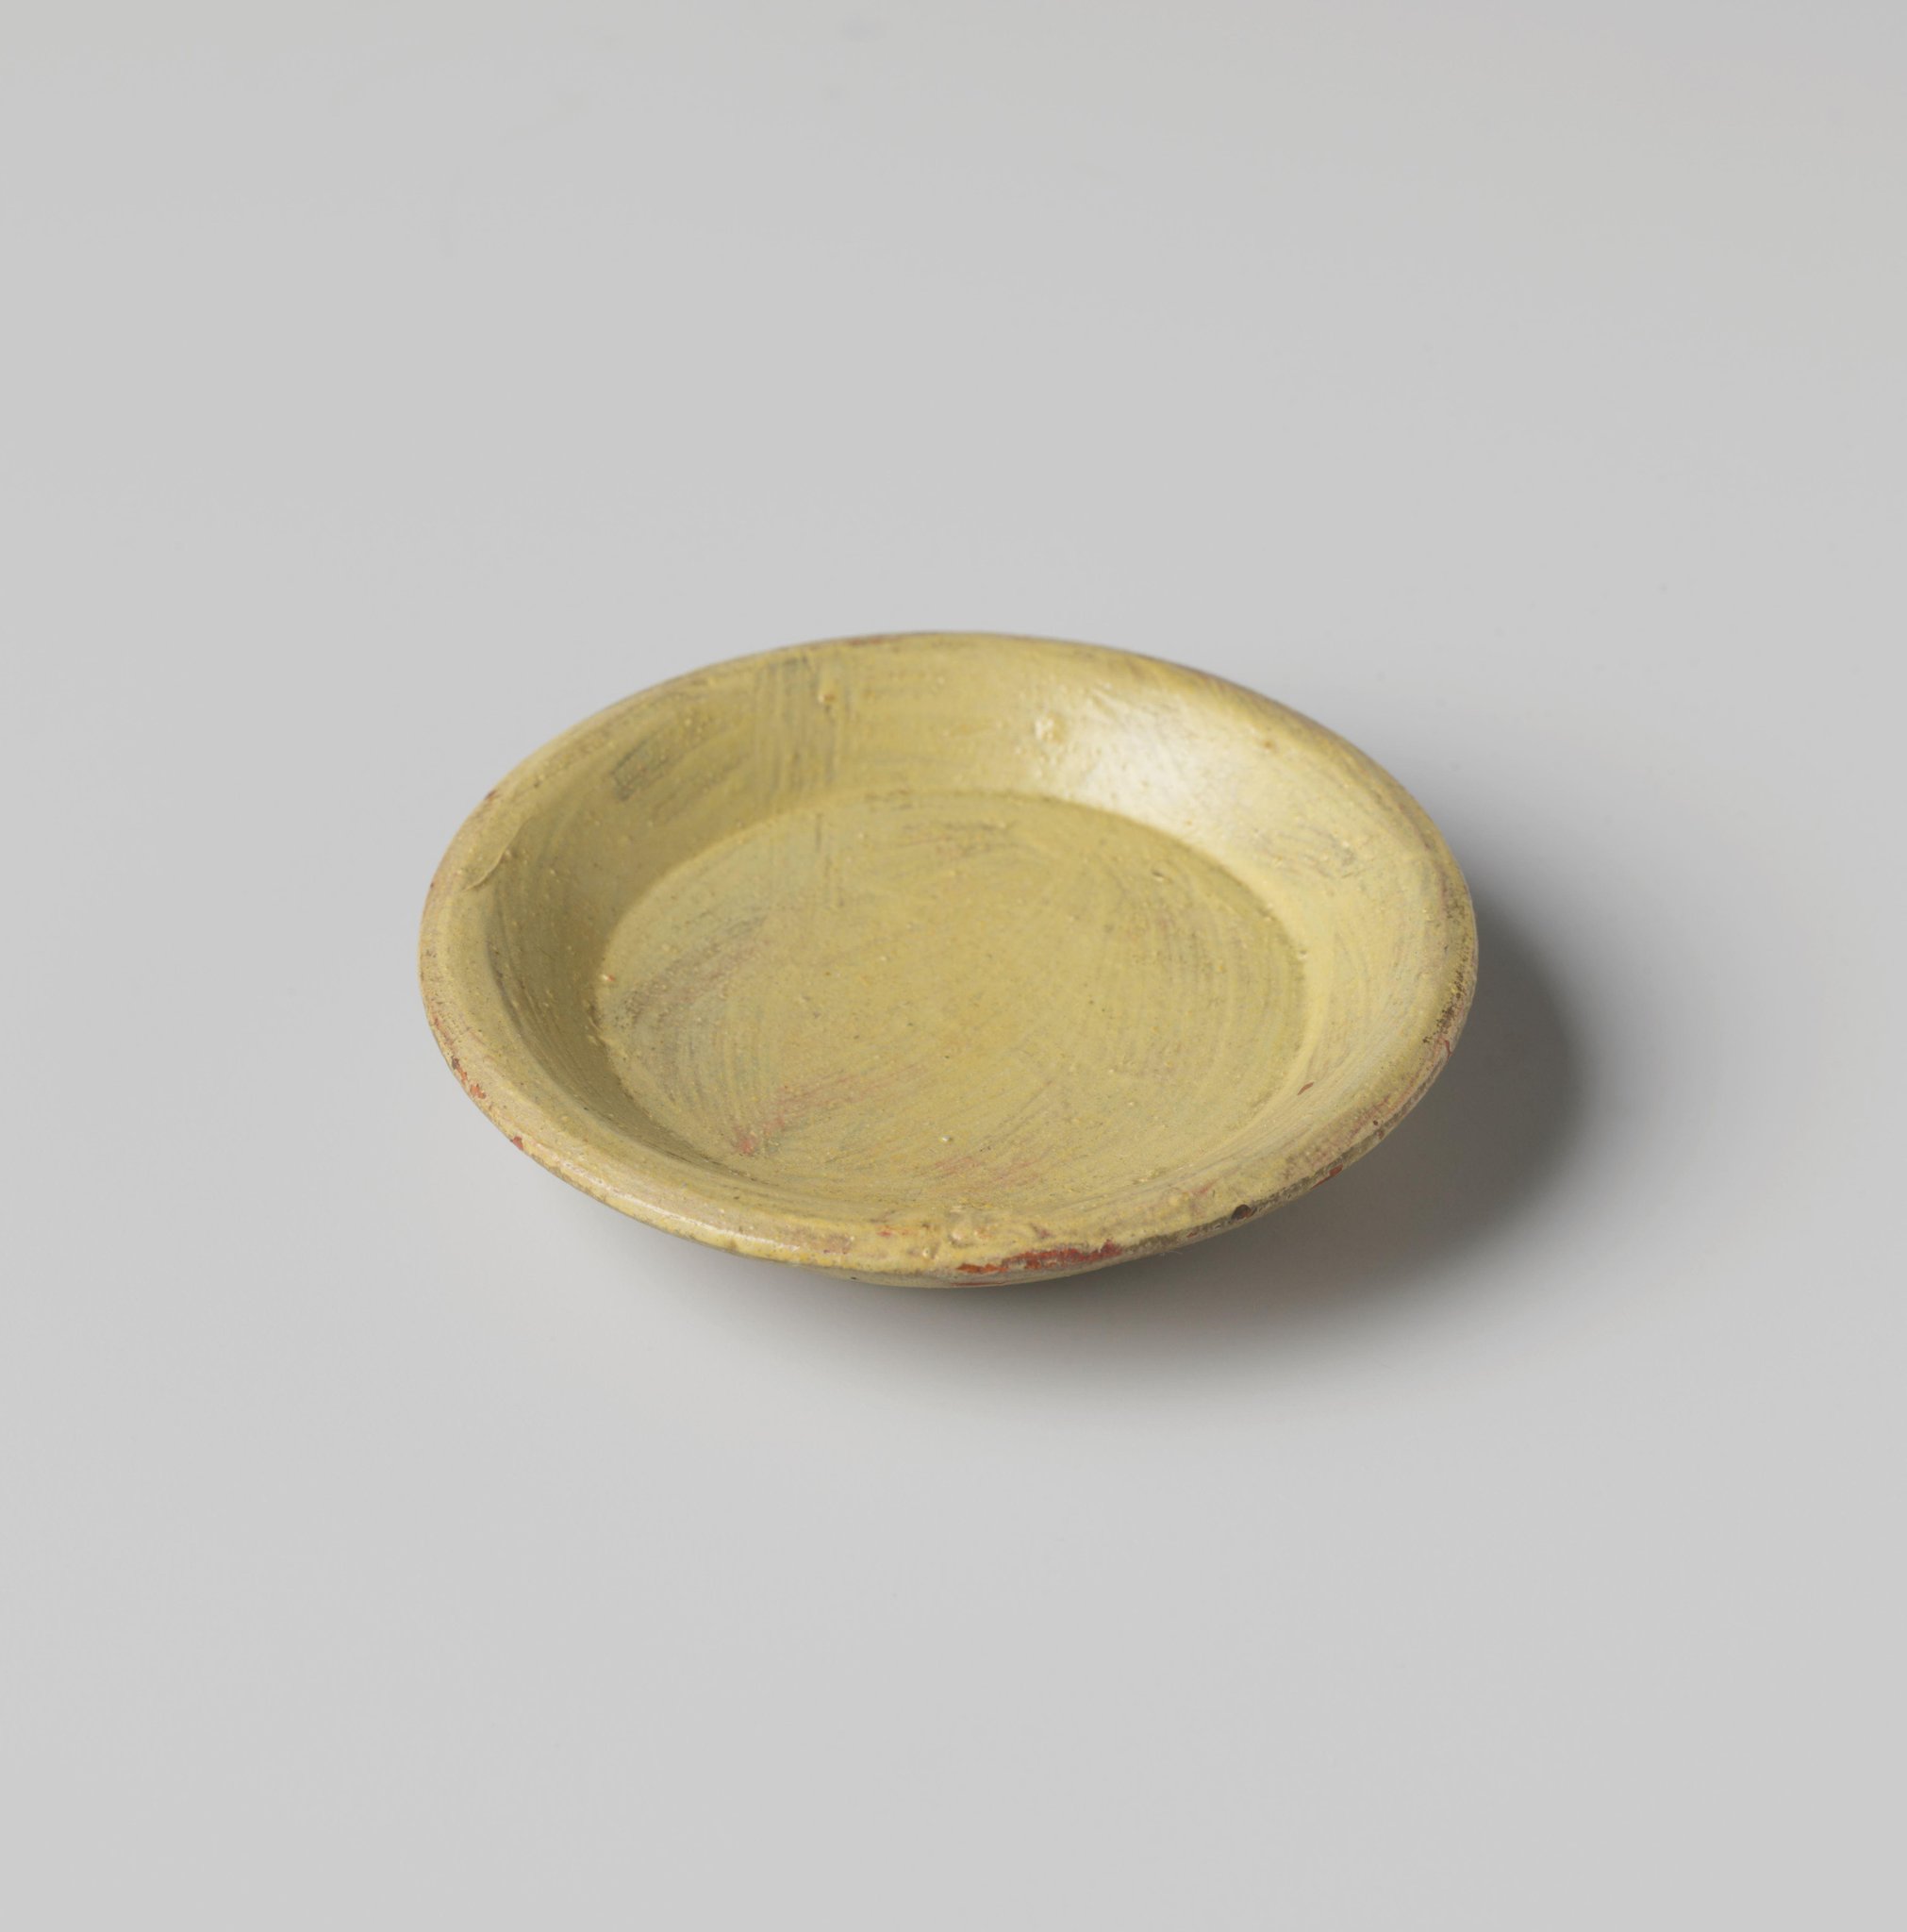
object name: miniature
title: Schotel, geelgeverfd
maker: Anonymous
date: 1675-1700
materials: wood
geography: amsterdam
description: Schotel van hout, geelgeverfd. Was oorspronkelijk rood.